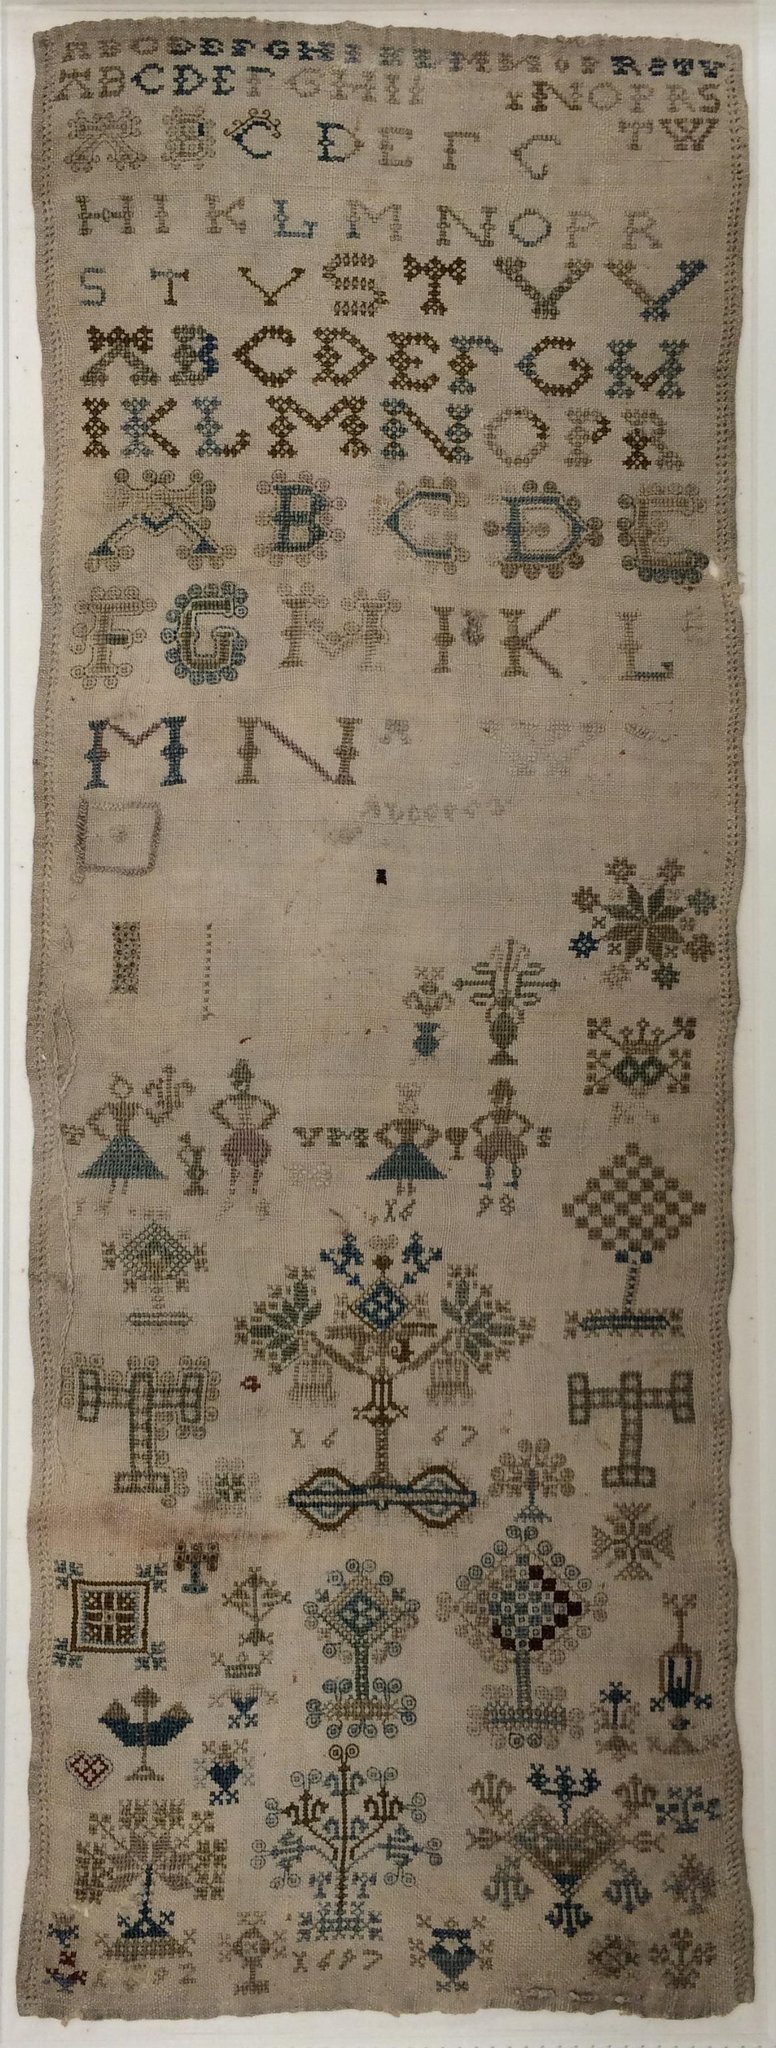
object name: sampler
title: Embroidered sampler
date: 1698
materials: linen, silk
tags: human figures,flowers